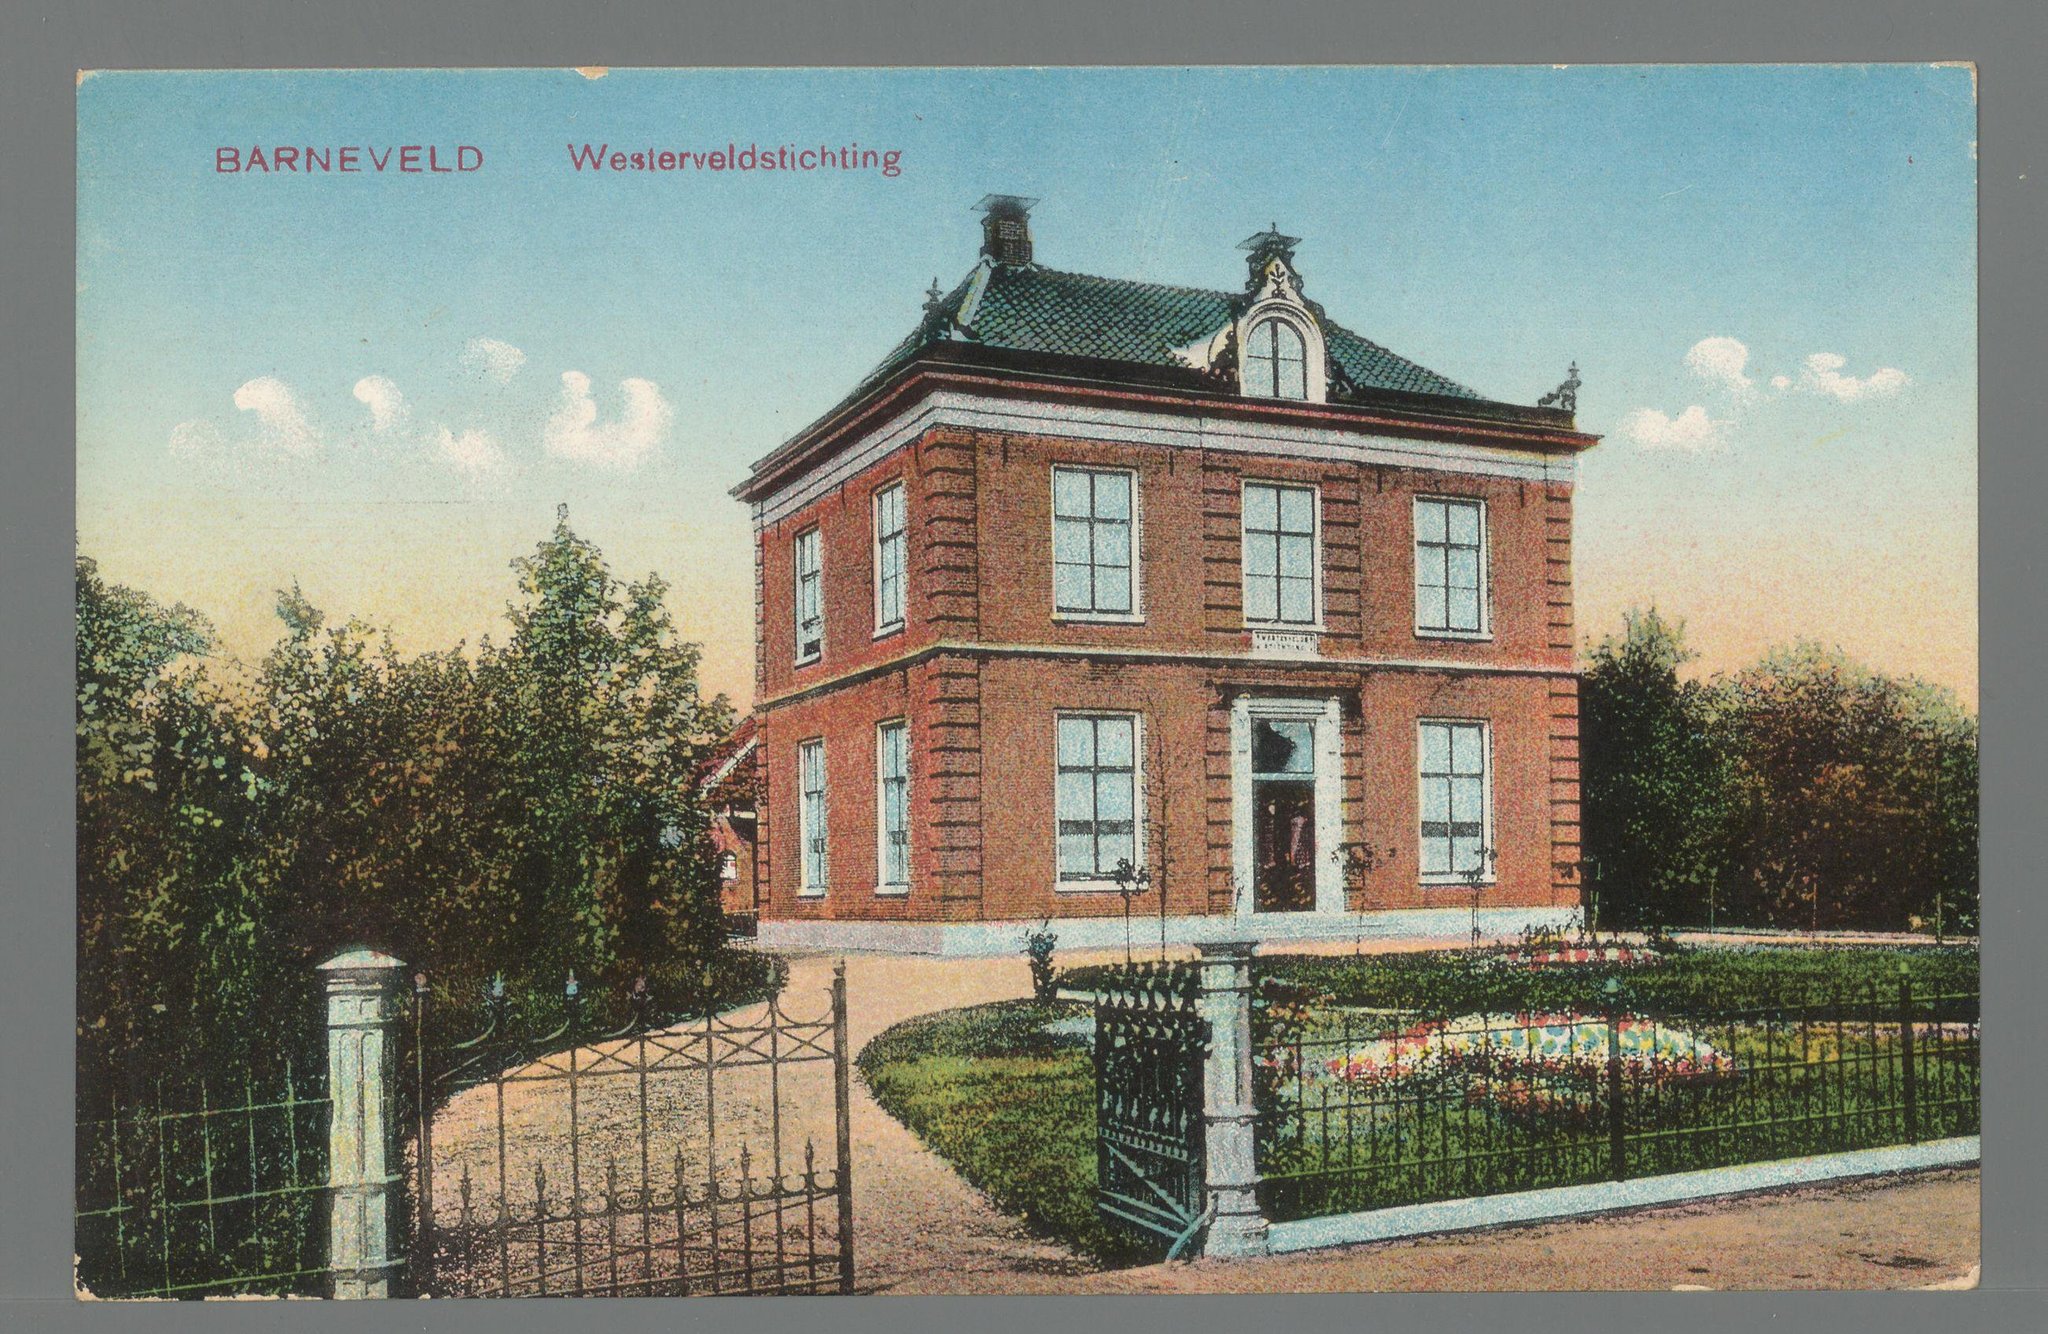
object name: ansichtkaart, prentbriefkaart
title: Barneveld. Westerveldstichting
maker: Anonymous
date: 1905-1930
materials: cardboard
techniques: photograph, lithograph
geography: barneveld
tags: fence, wall, paling, villa